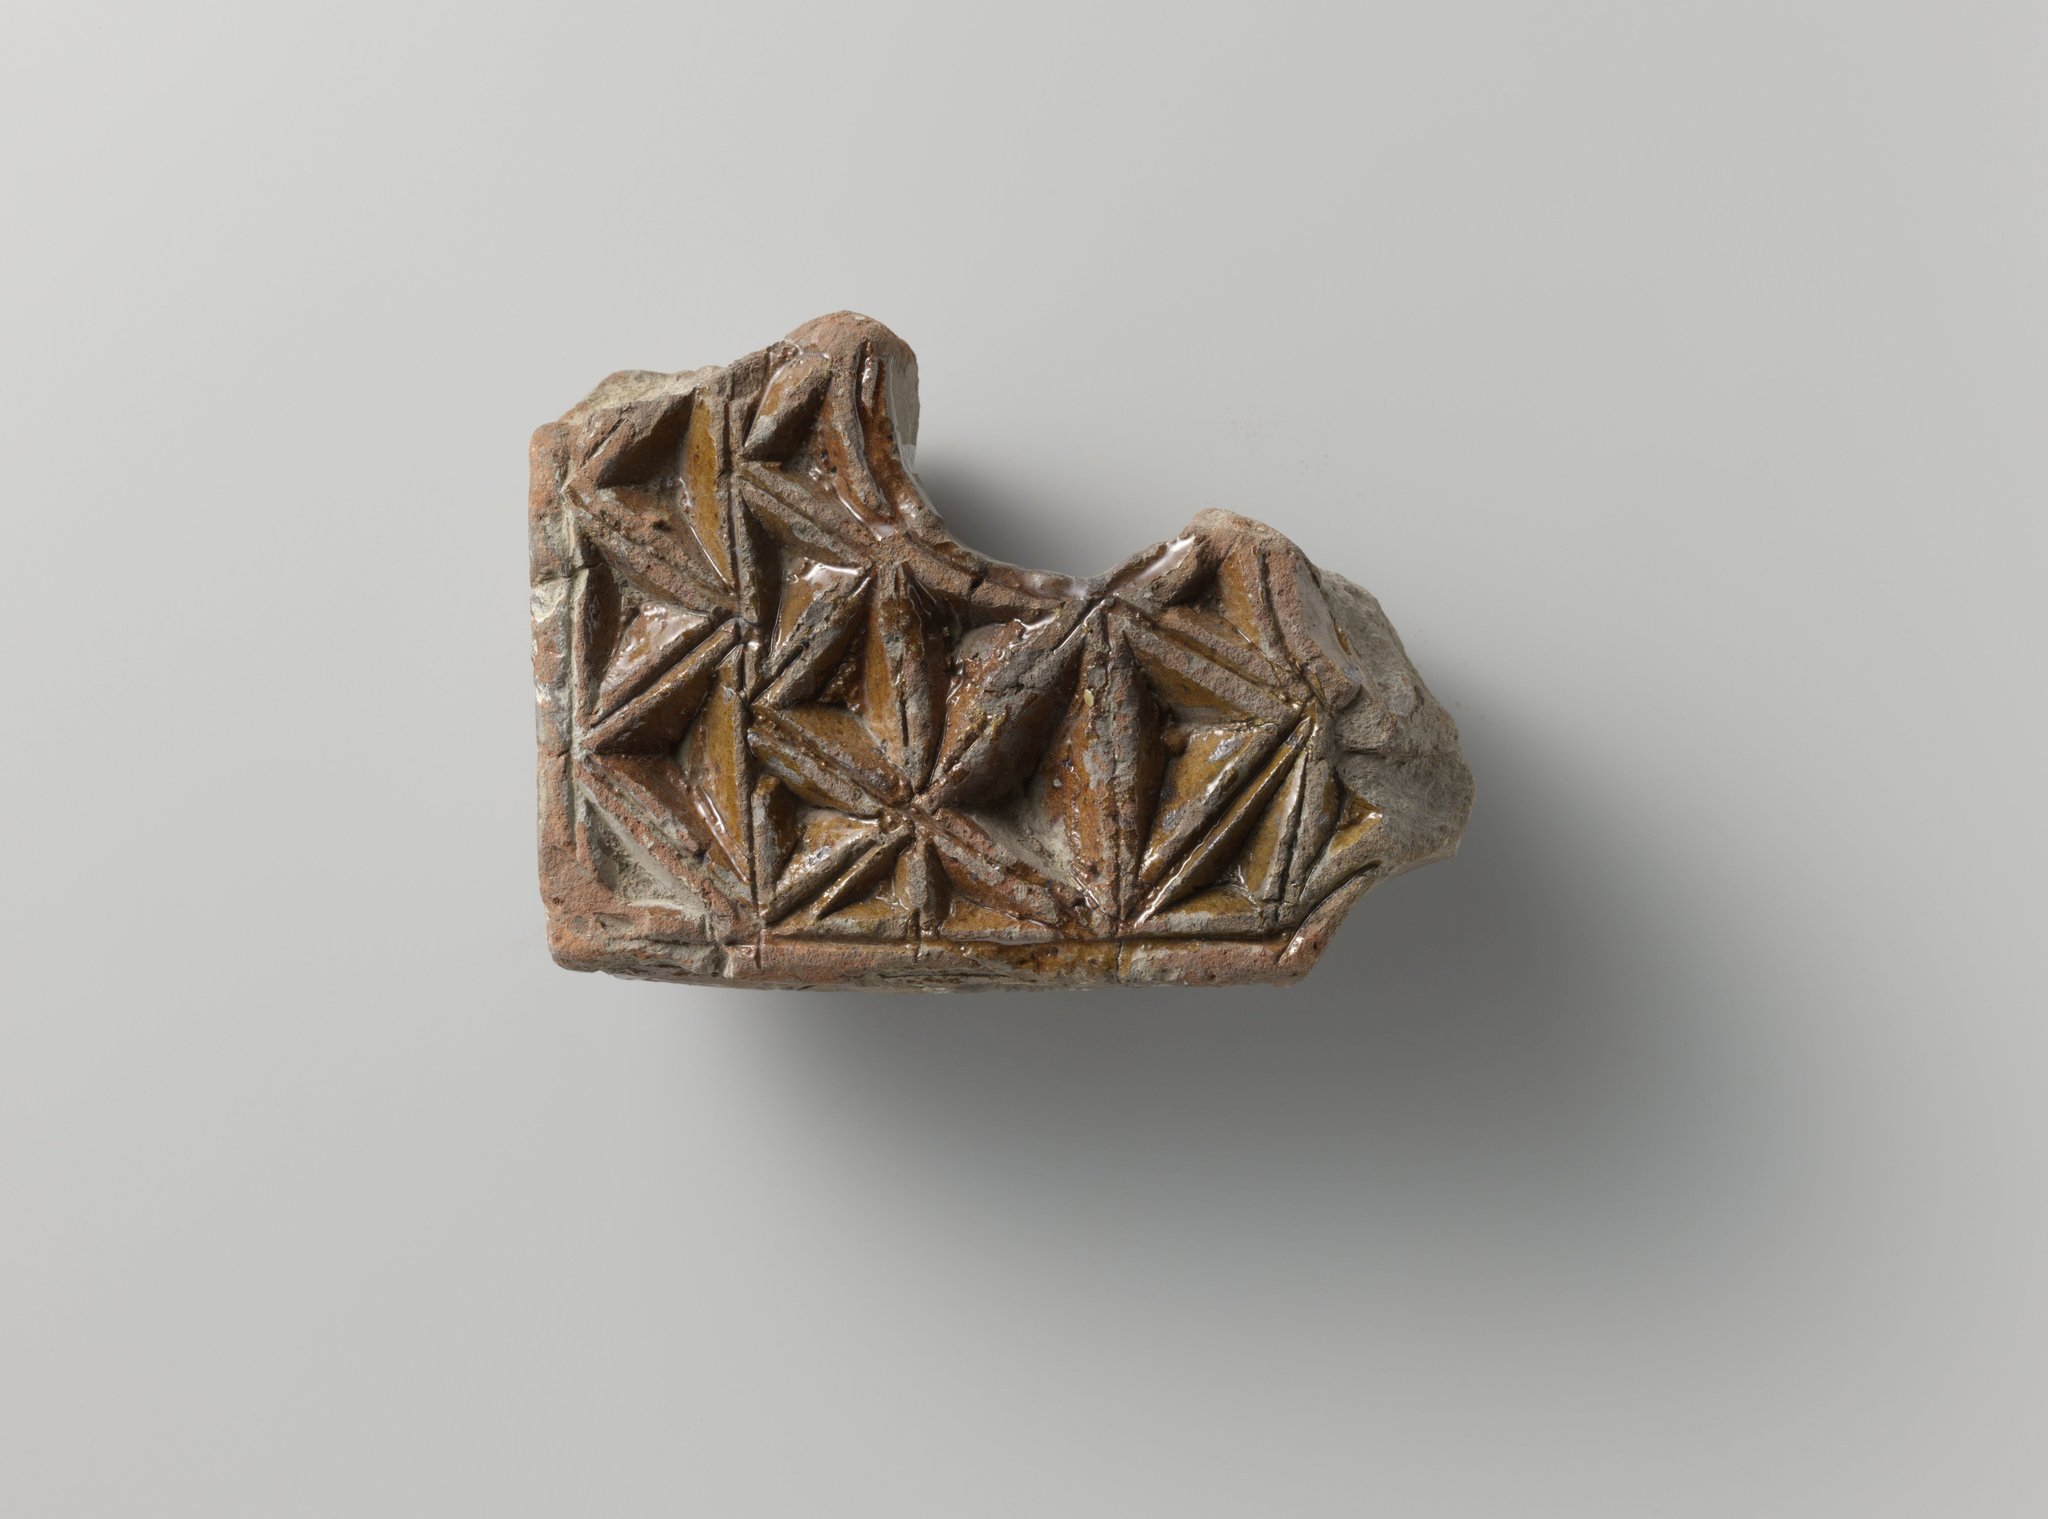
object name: architectural element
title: Bouwfragmet, versierd met verdiepte driehoeken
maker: Anonymous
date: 1450-1550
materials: earthenware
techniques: firing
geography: netherlands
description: Bodemvondst: Gevonden bij de doorgraving van de grote weg van Utrecht naar Vreeswijk tegenover het huis "de Wiers" bij het uitvoeren van de Rijks werken van het Kanaal Amsterdam-Merwede. Samen met inv. nr. BK-NM-8413-B.